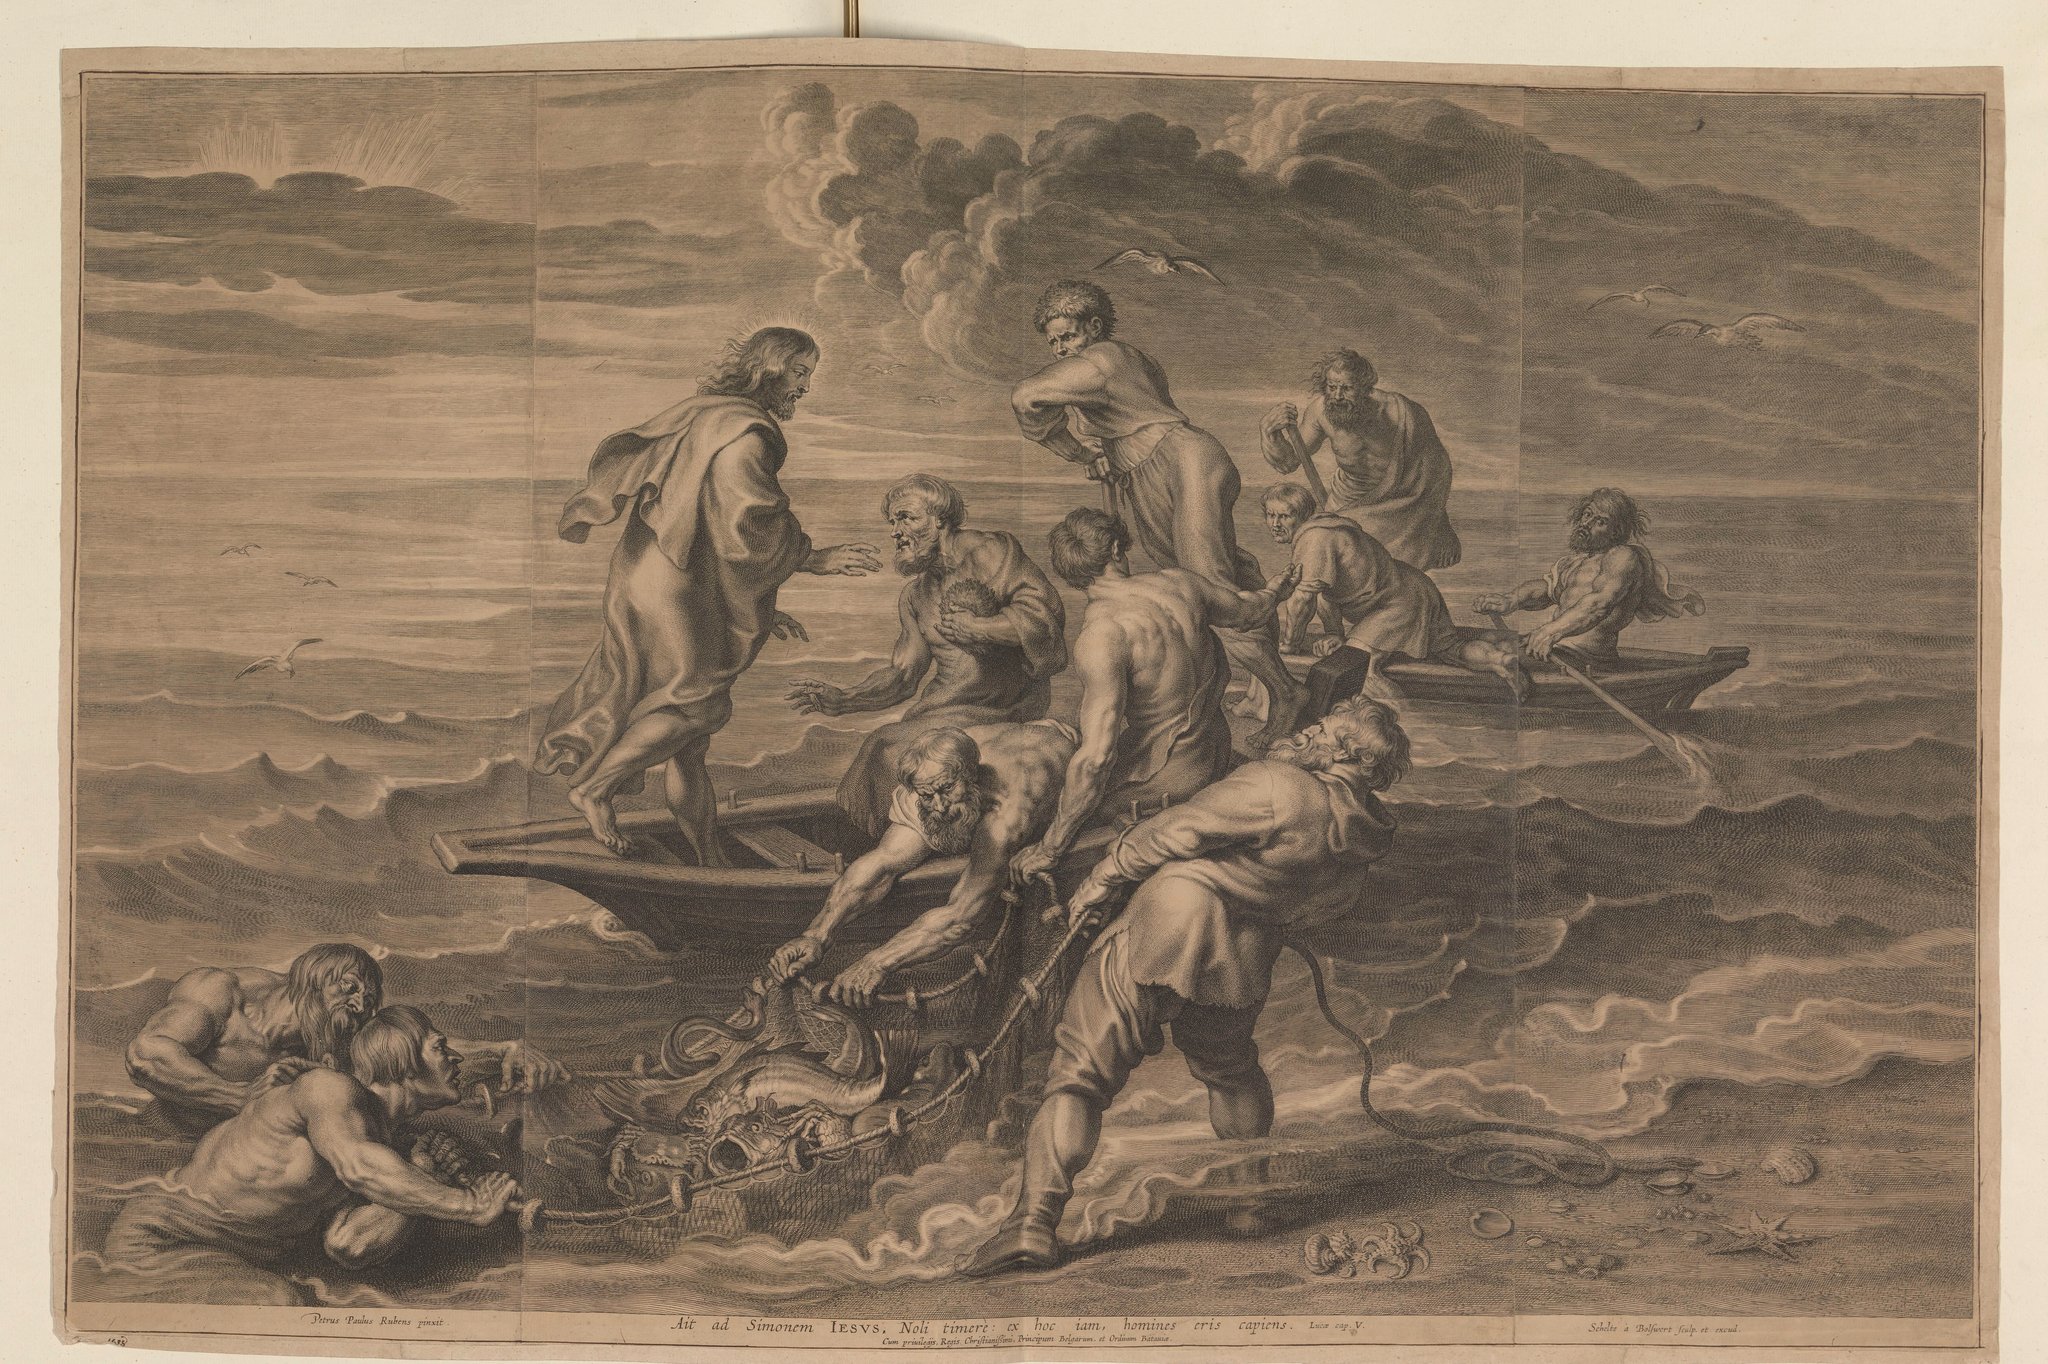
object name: print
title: Wonderbare visvangst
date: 1596-1659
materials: paper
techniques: engraving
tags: the miraculous draught of fishes (before the resurrection) on the lake of gennesaret (sea of galilee); james and john helping to bring in the nets (luke 5:1-11)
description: Twee vissers staan tot hun middel in het water en houden de rand van het visnet vast. Ze kijken vol verbazing naar het net vol vissen. Gedrukt van drie platen. Deze prent maakt deel uit van een album.